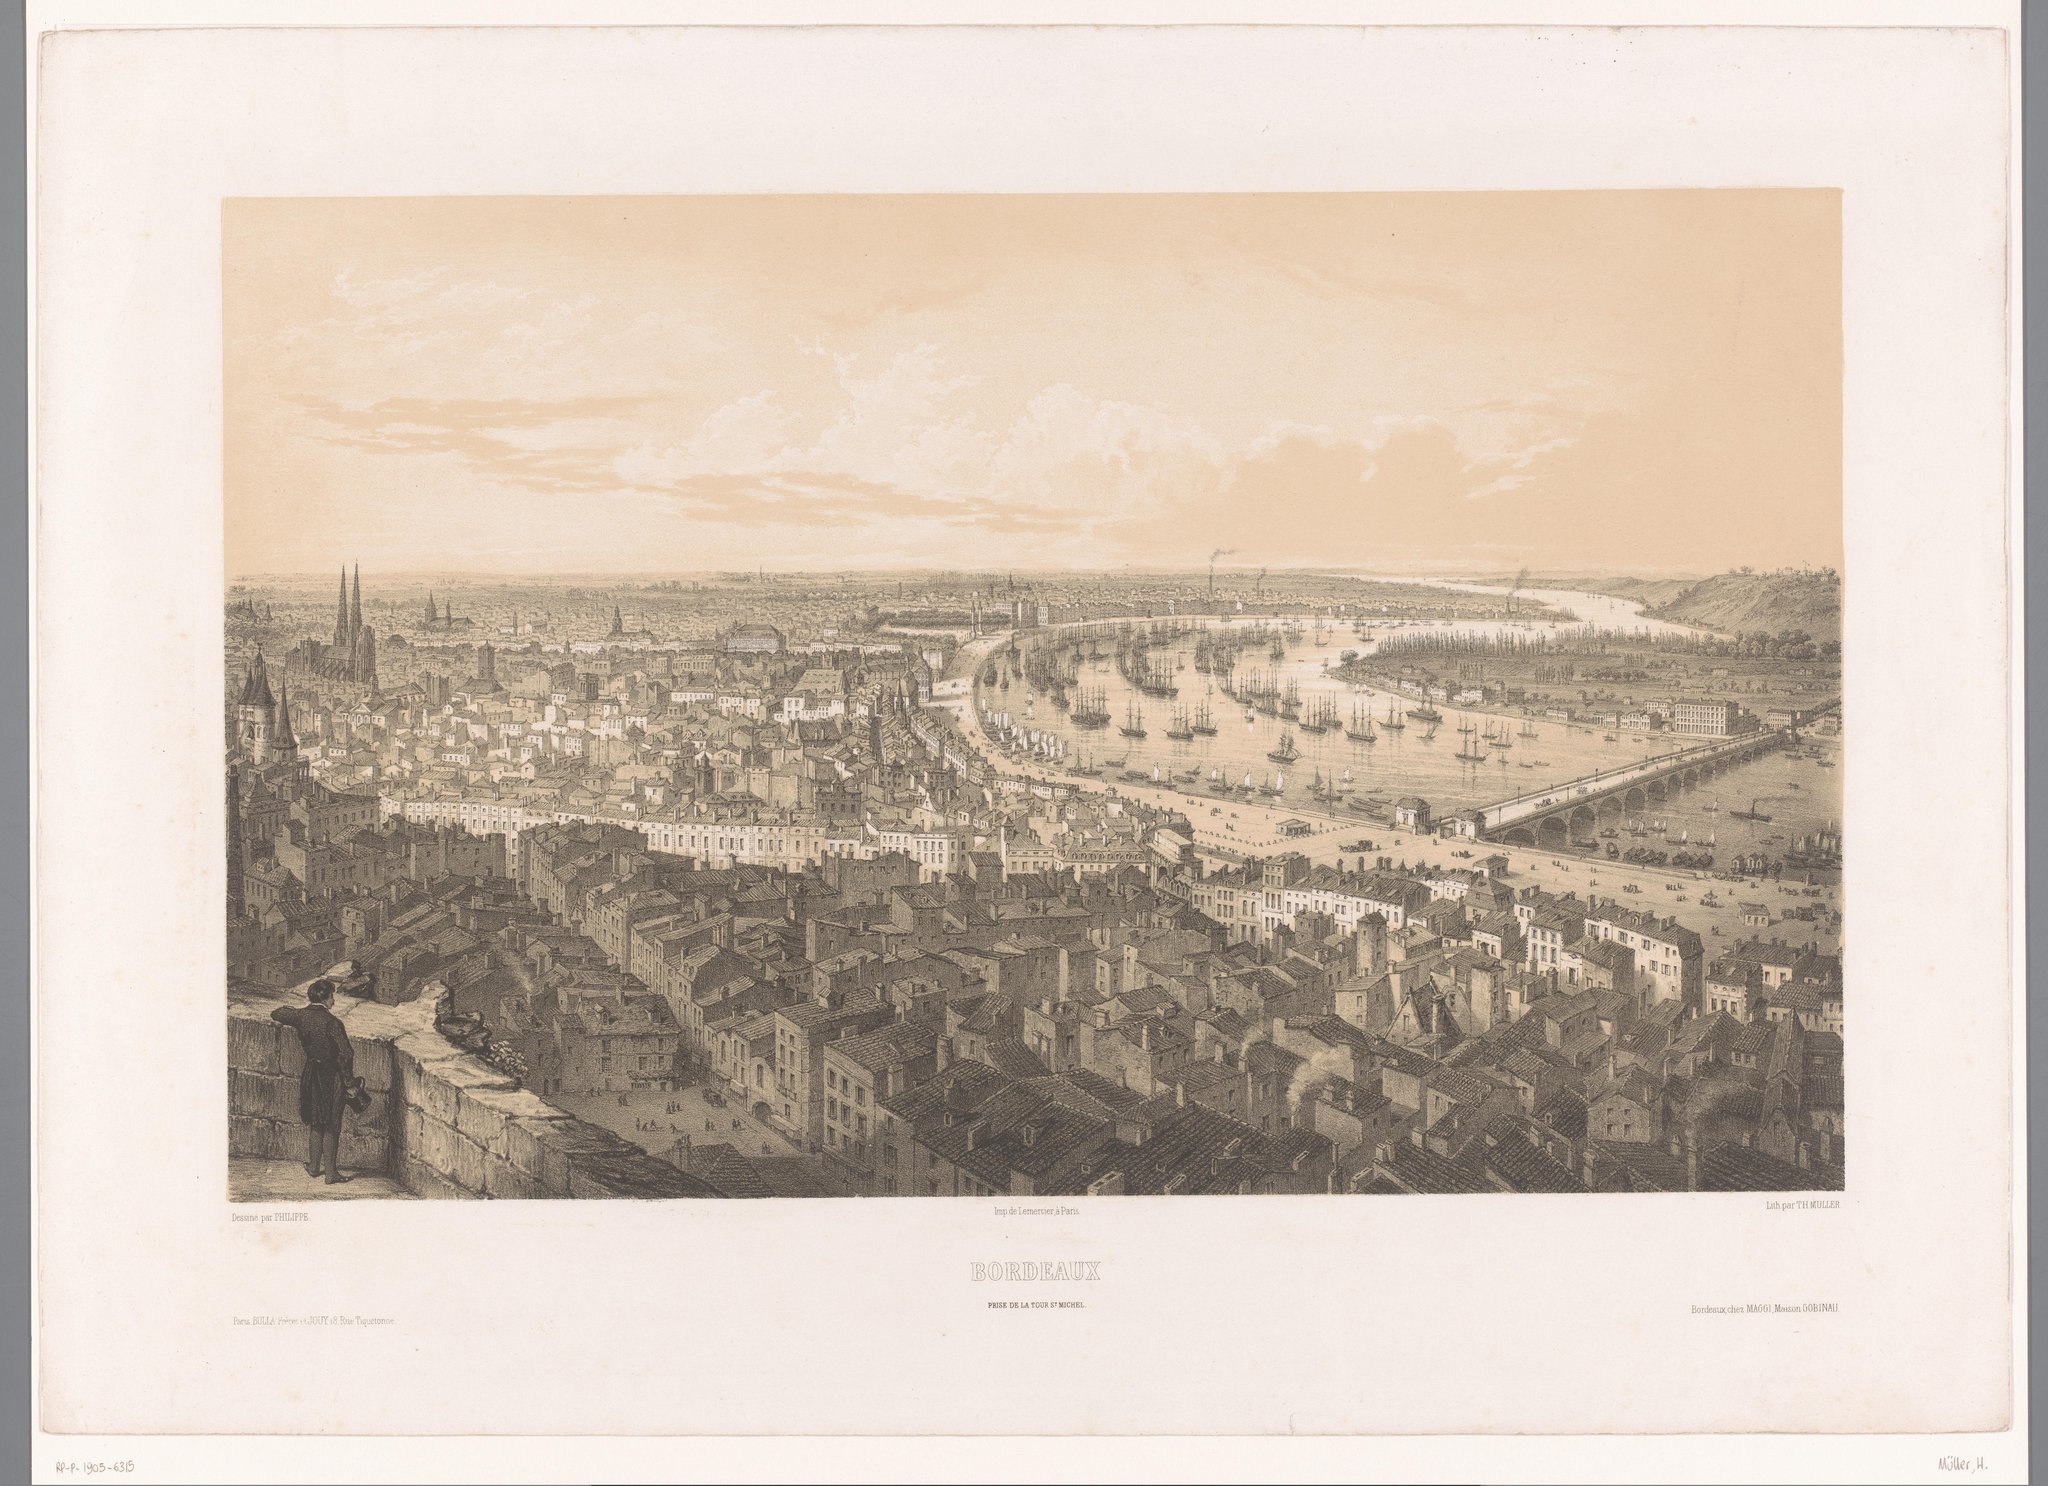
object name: print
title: Gezicht op Bordeaux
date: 1846-1869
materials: paper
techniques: tone lithography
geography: bordeaux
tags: city-view, and landscape with man-made constructions, sailing-ship, sailing-boat, river, church (exterior)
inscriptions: collector's mark: Lugt 2228